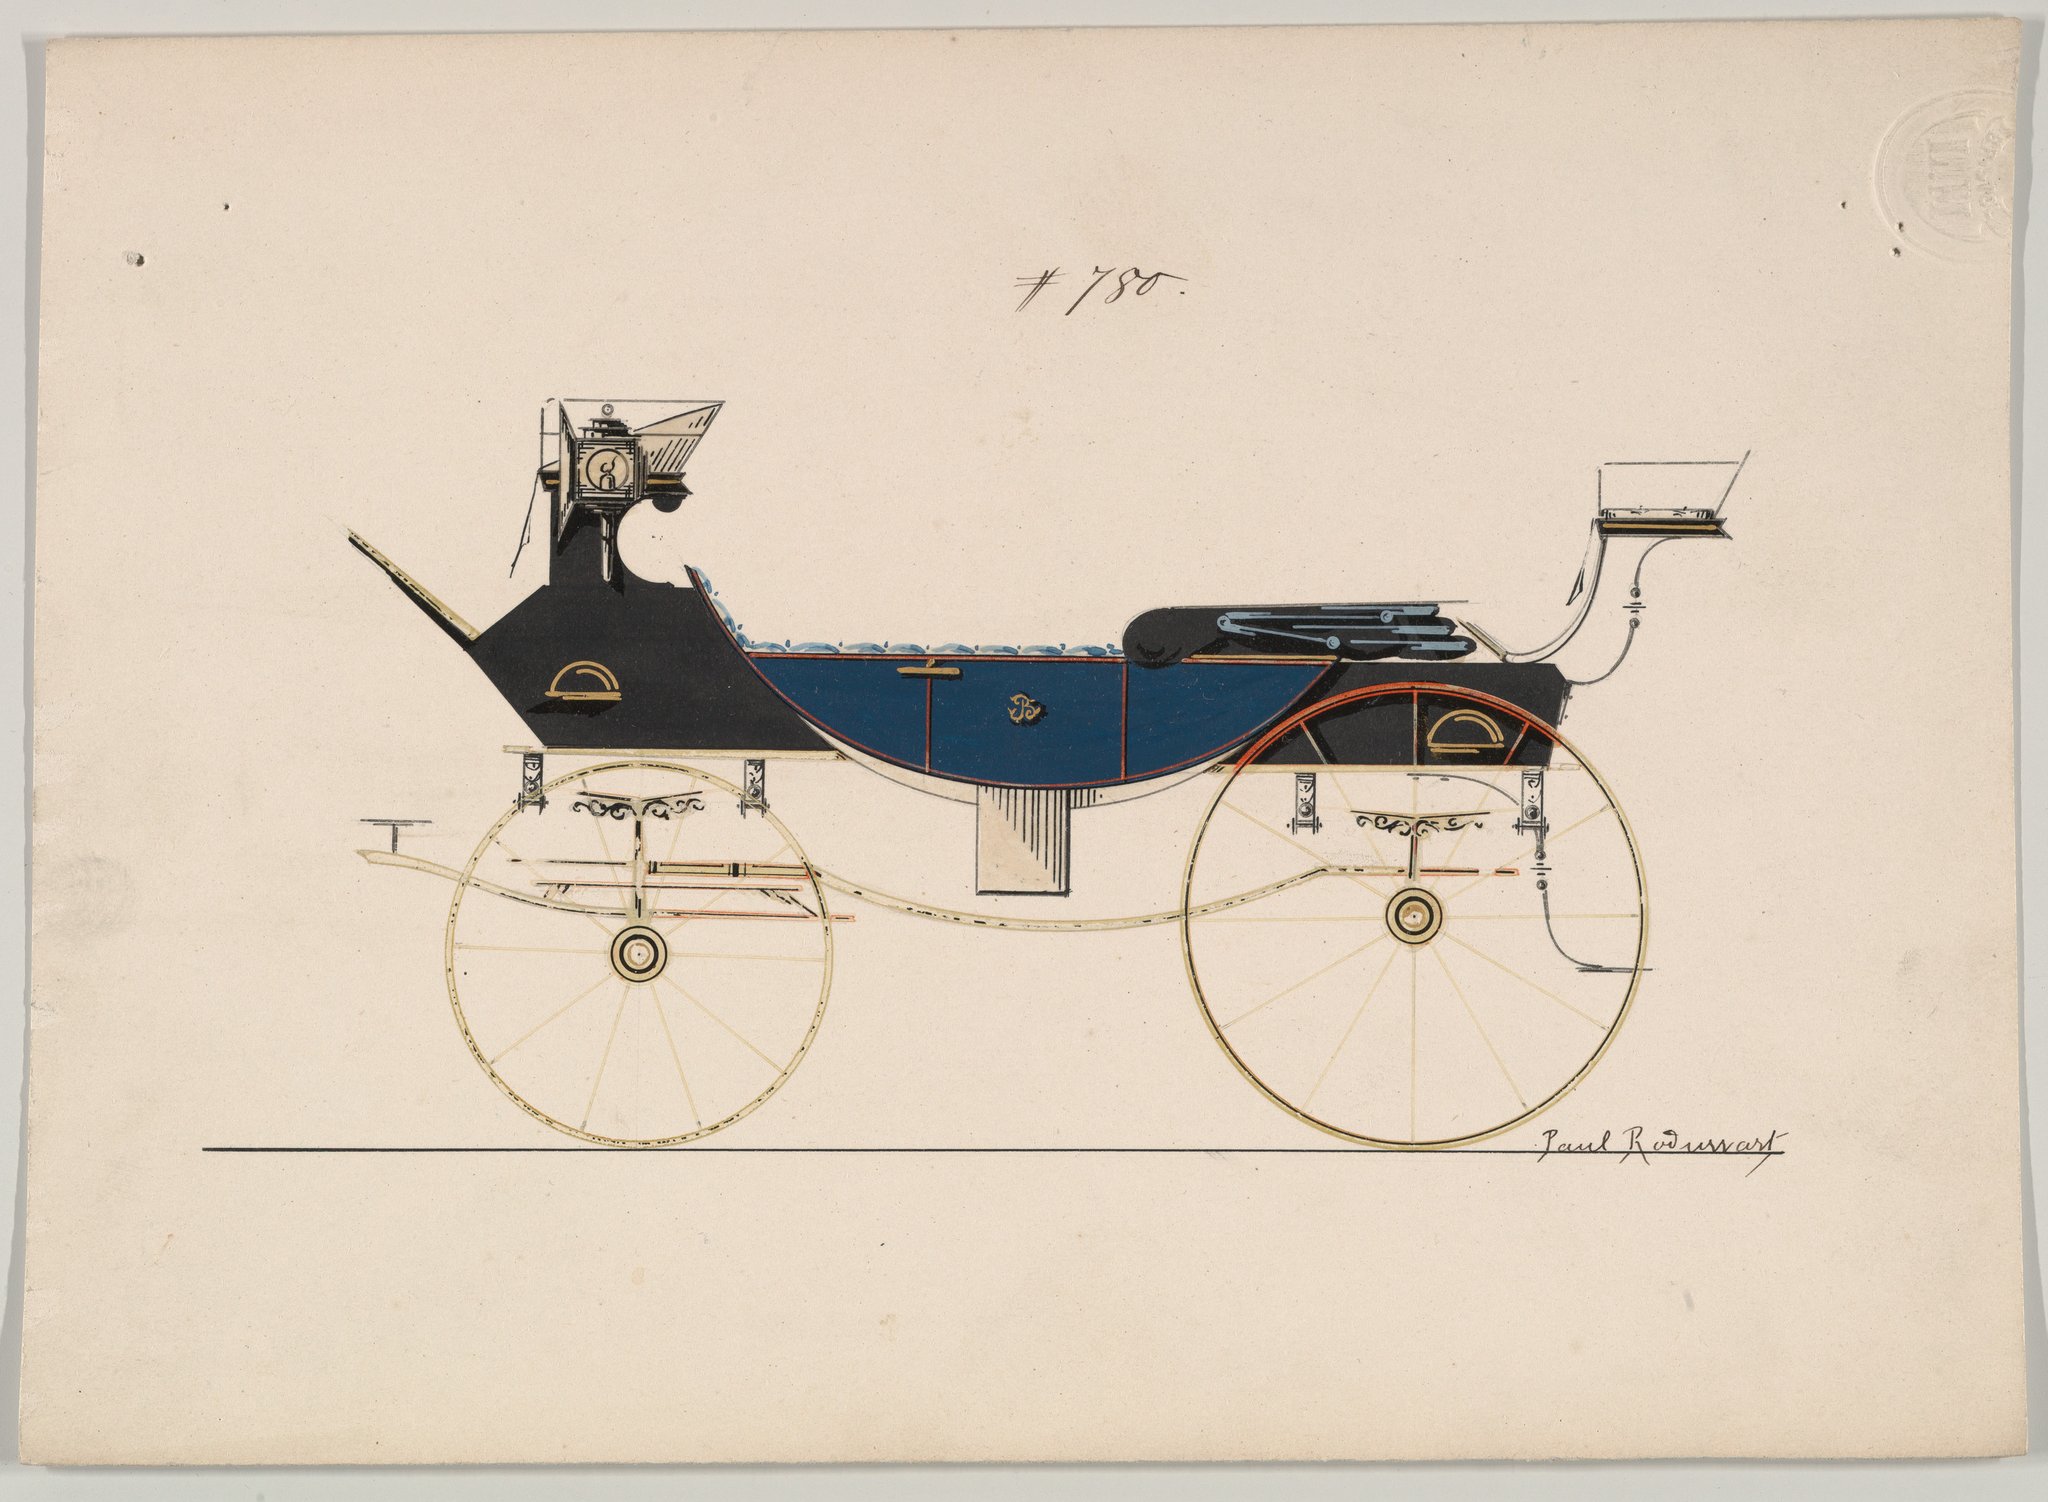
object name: drawing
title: Caleche with Drag Front #780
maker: brewster & co.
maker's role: manufacturer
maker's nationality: american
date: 1850-1870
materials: gouache, gum arabic, ink, watercolor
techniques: pen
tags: carriages